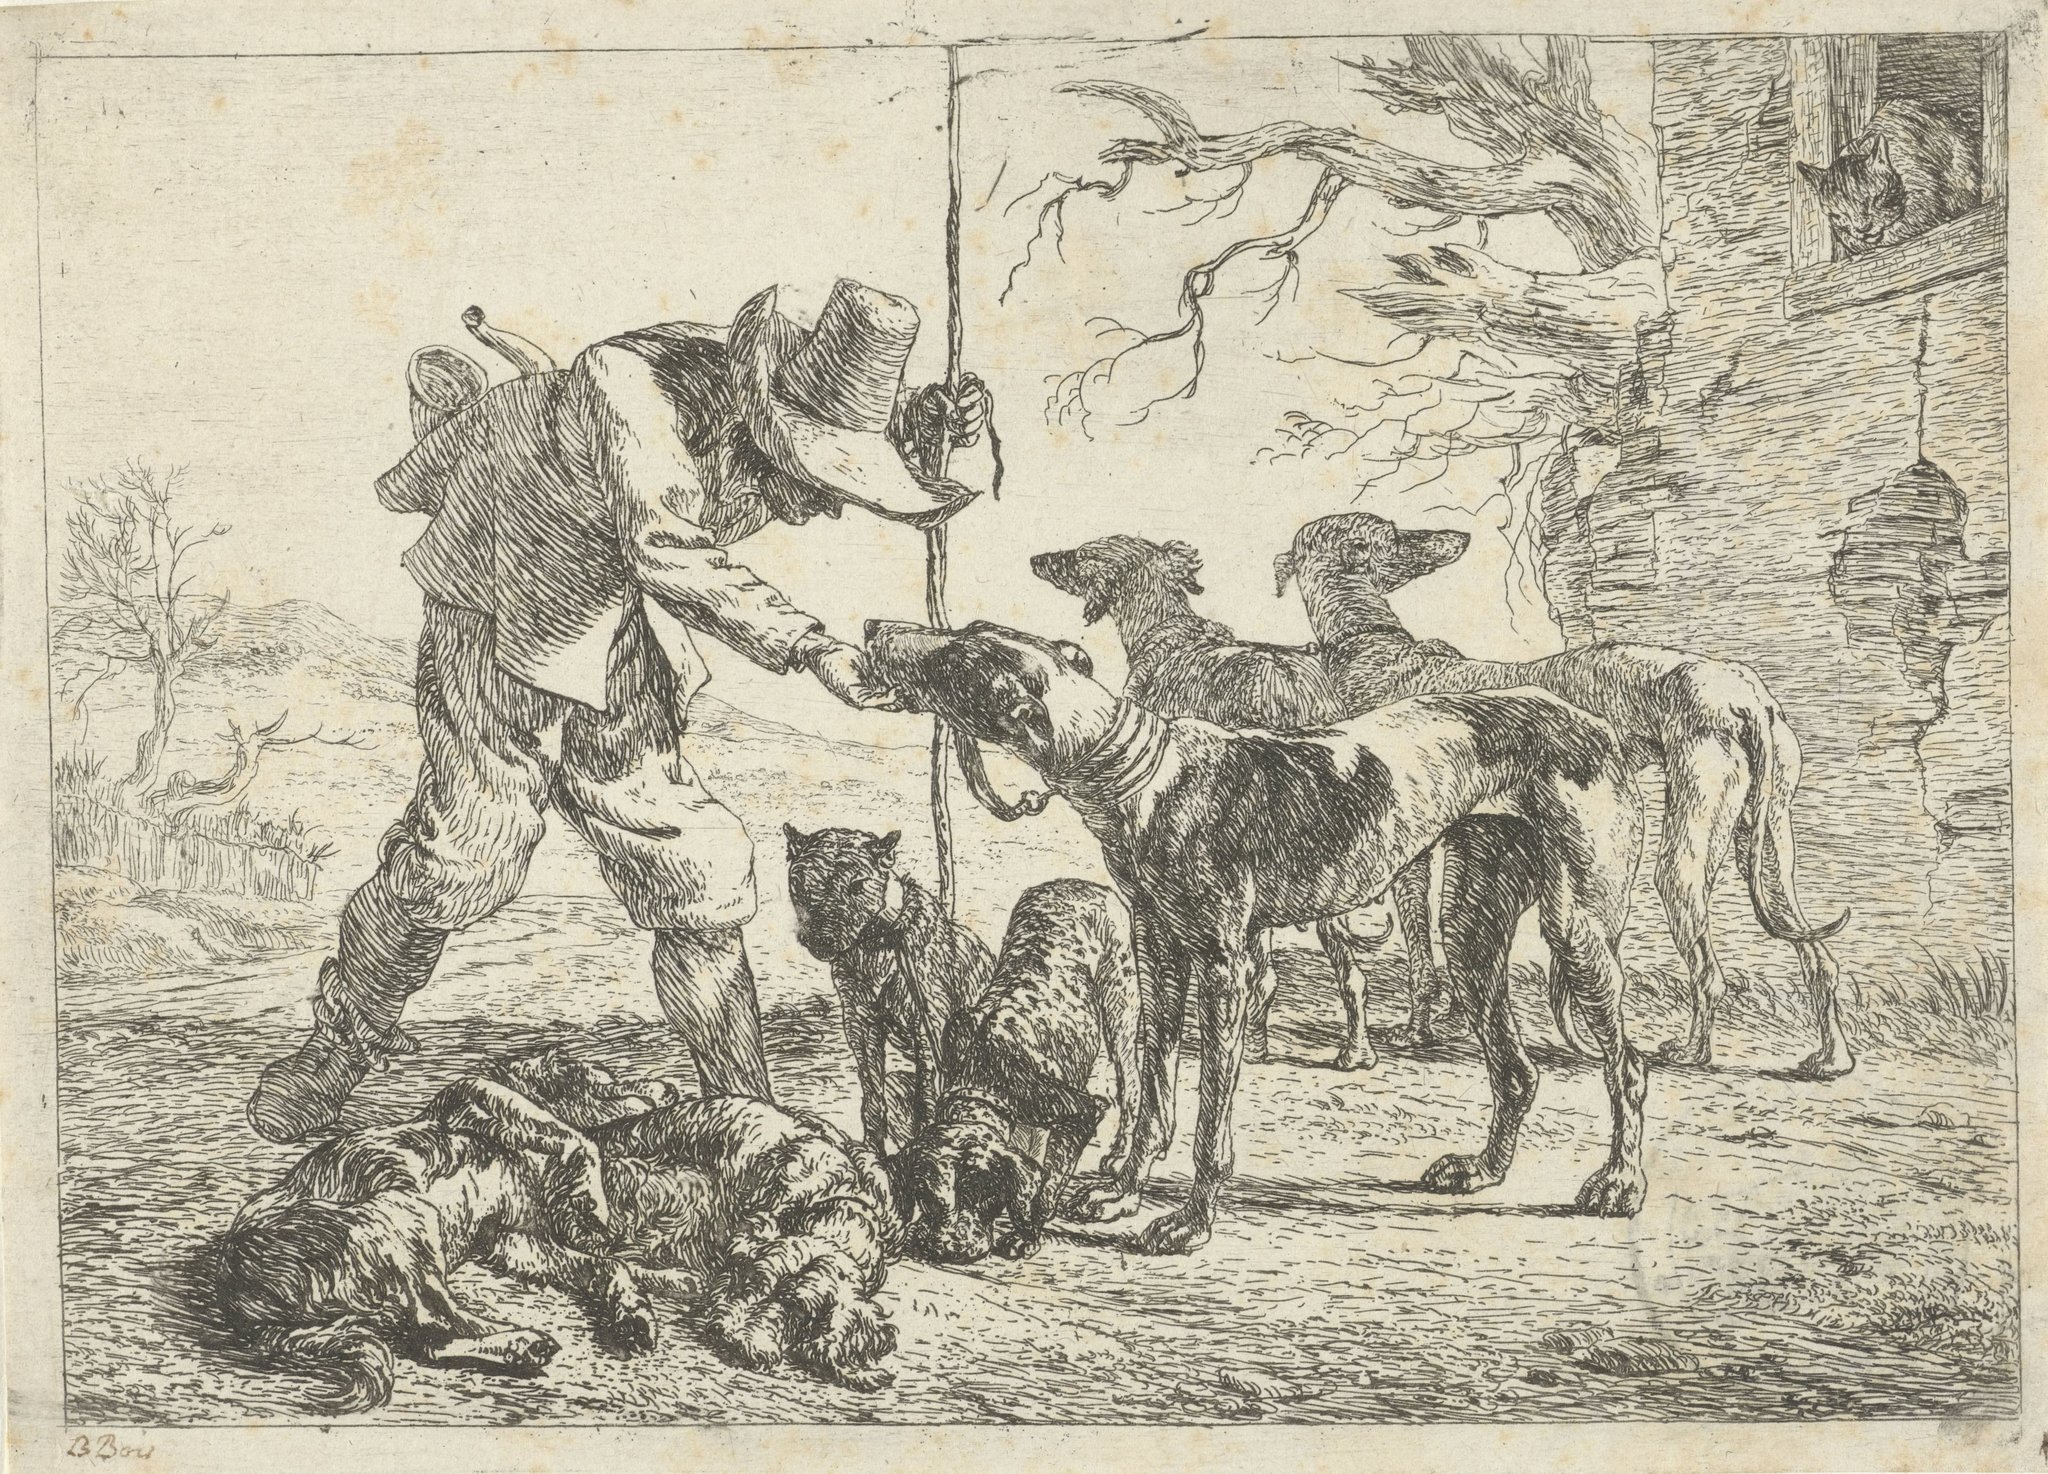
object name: print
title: Jager met zeven honden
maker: pieter bodding van laer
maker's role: draughtsman, painter, print maker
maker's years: 1599-1642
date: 1636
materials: paper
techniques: etching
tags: cat, hunting dogs, hunter, friendship between man and animal; caressing, petting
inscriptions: collector's mark: Lugt 11, inscription: ‘B Bois (?)’, number: ‘1’, collector's mark: Lugt 10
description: Een jager aait één van zijn zeven jachthonden onder de kin, rechts zit een kat in het raamkozijn. De prent maakt deel uit van een achtdelige serie met voorstellingen van verschillende dieren.